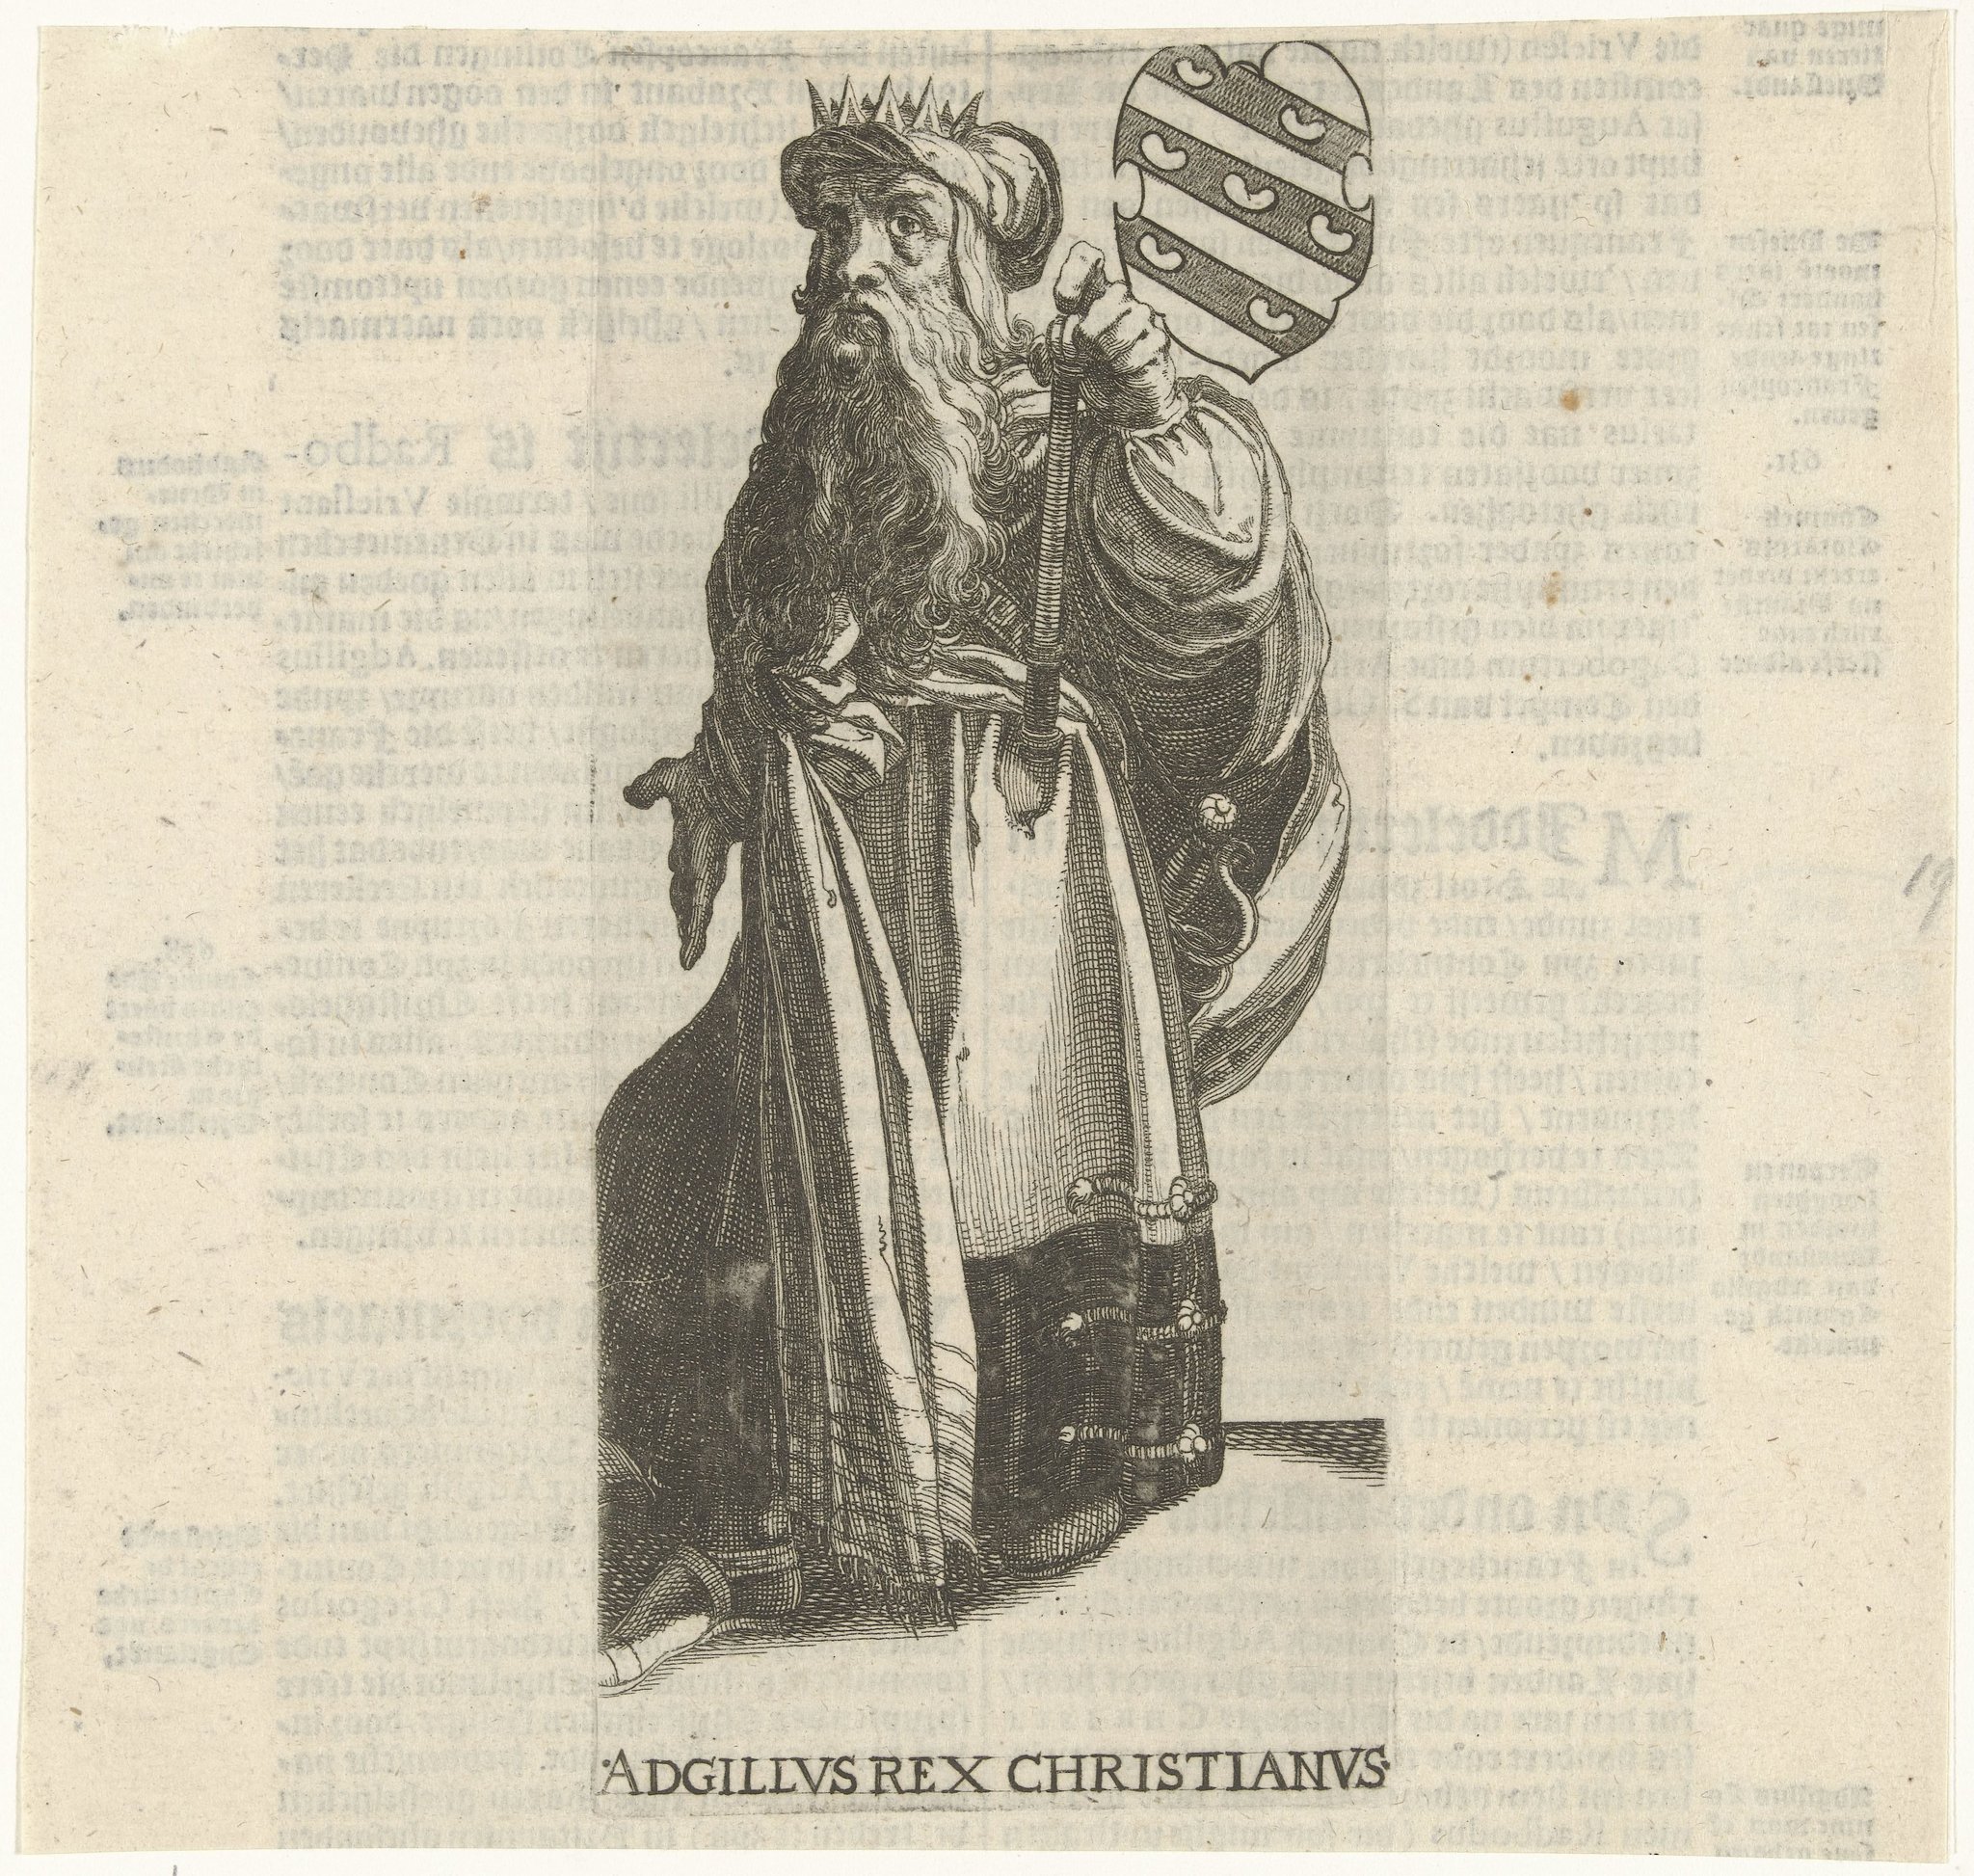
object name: print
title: Adgillis I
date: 1622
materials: paper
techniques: etching, letterpress printing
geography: northern netherlands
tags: koning, adgild i (koning der friezen)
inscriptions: collector's mark: Lugt 2228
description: De prent is ook als boekillustratie gebruikt in: Winsemius, P.W. Chronique ofte Historische geschiedenisse van Vrieslant (...). Franeker: Joannes Lamrinck, 1622.